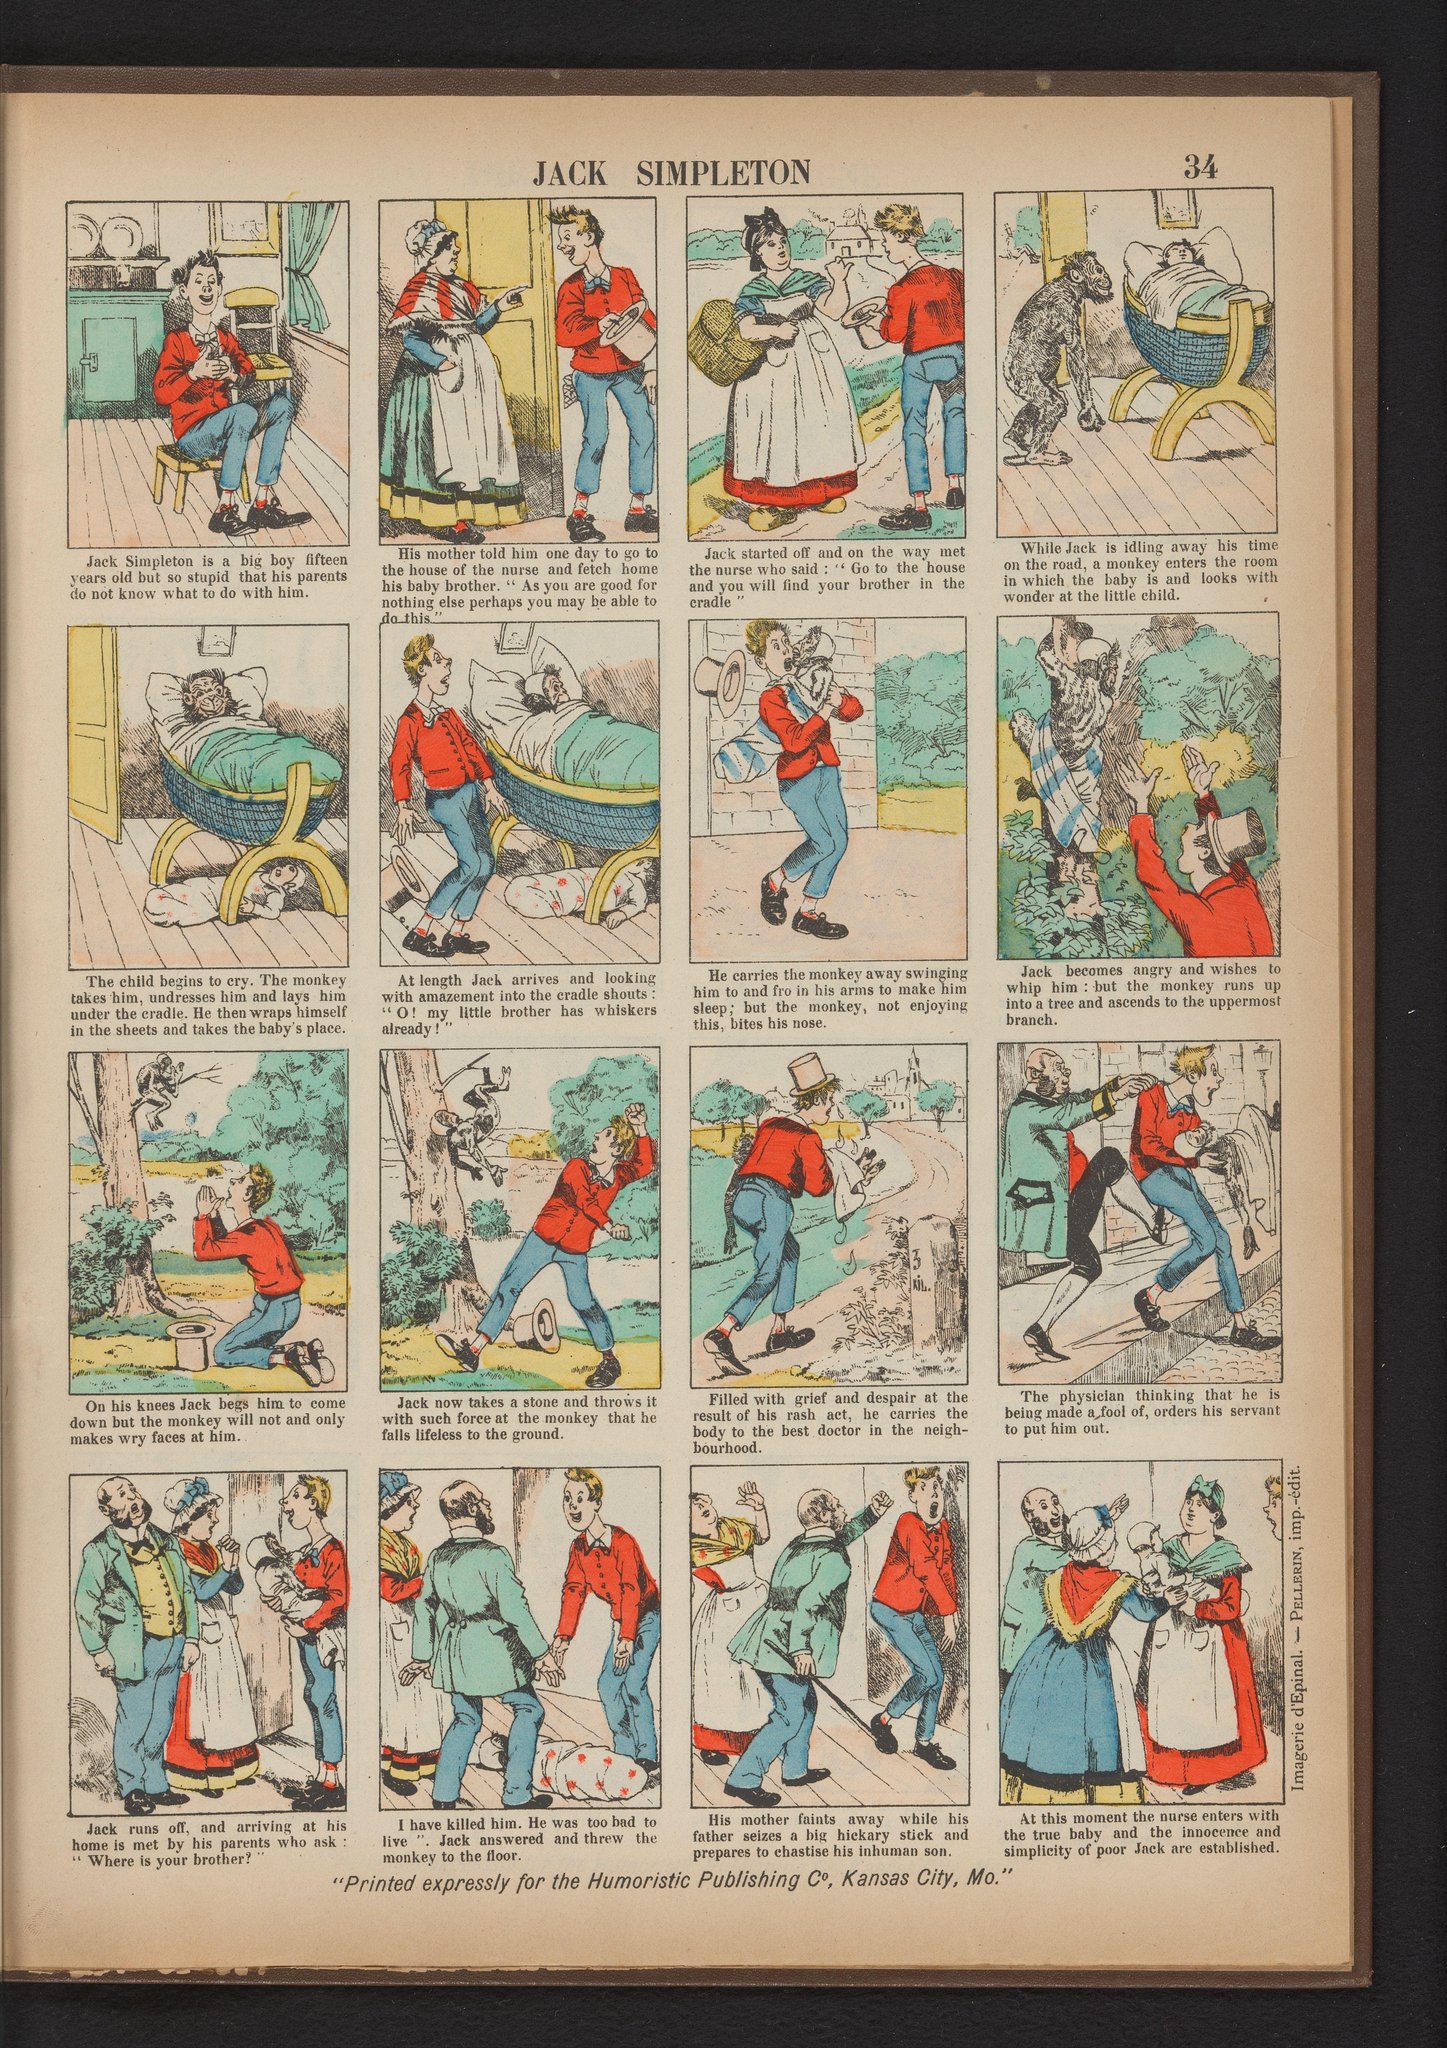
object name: popular print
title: Domkop Jack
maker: Anonymous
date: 1893-1894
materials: paper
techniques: colour, letterpress printing, lithograph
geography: kansas city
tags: monkeys, apes, fool, simpleton, numskull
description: Blad met zestien voorstellingen die het verhaal vertellen van de simpele ziel Jack. Onder elke voorstelling een onderschrift in het Engels. Deze prent maakt deel uit van een album.